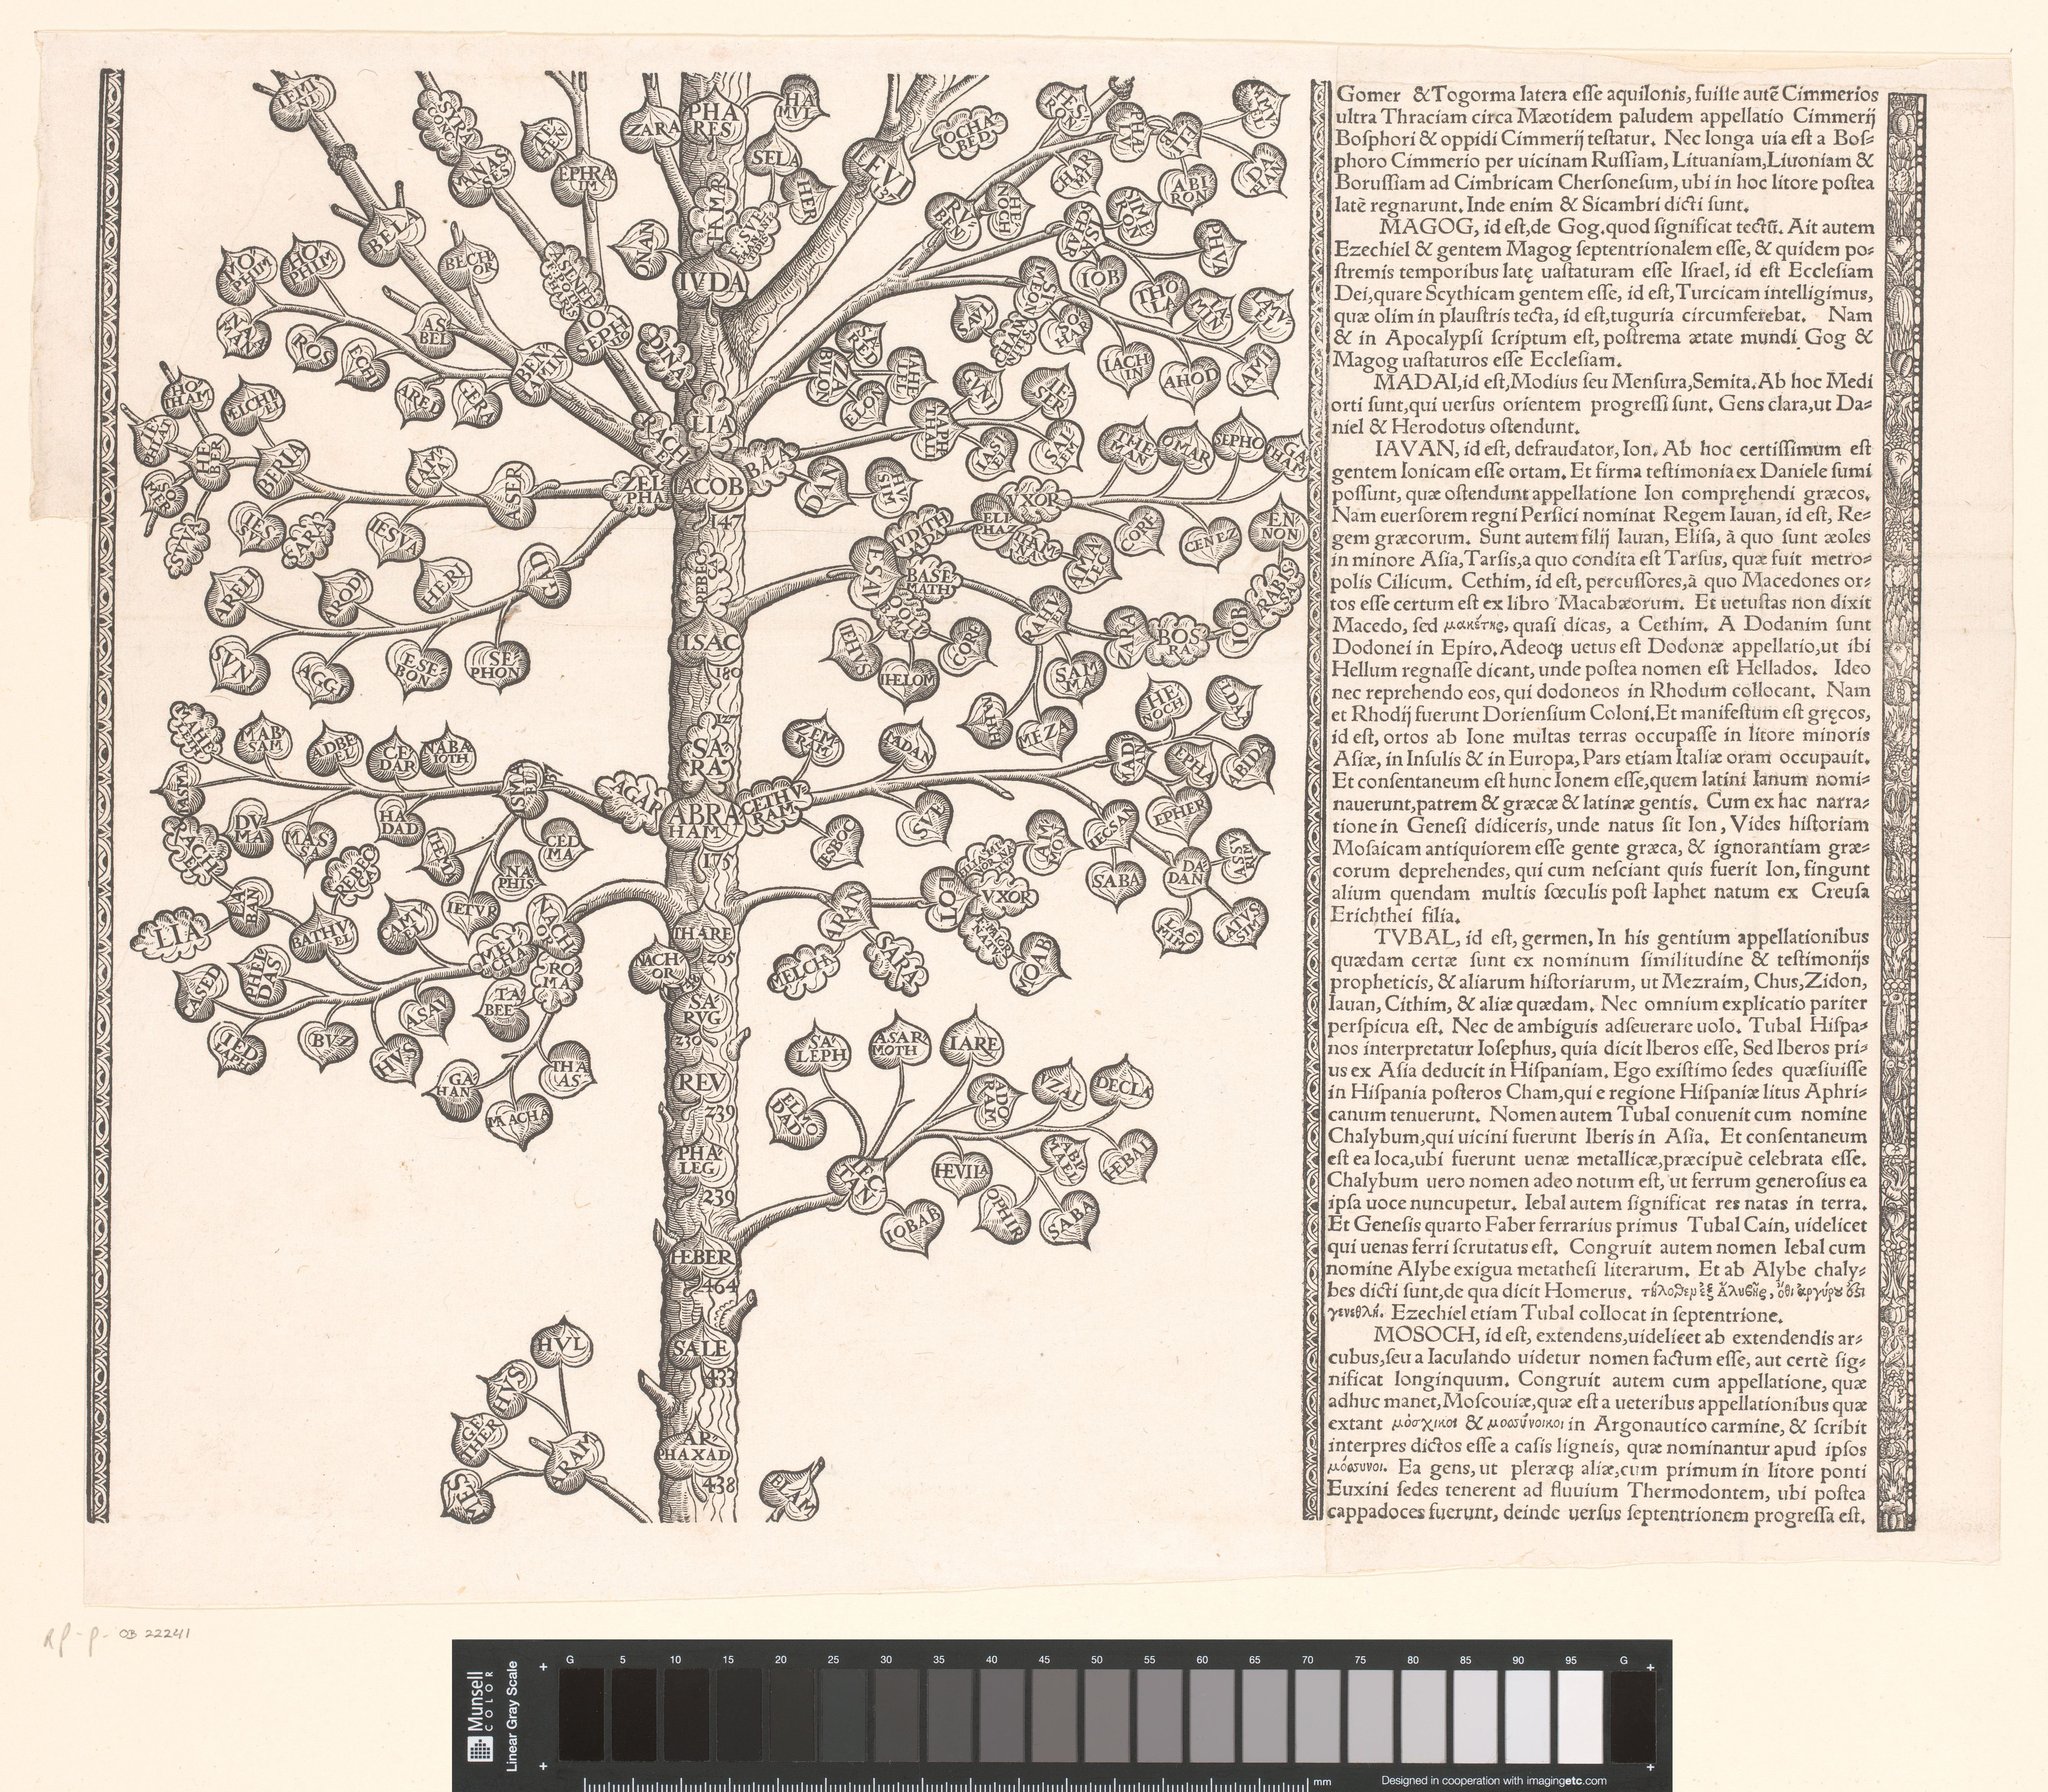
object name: print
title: Stamboom van Christus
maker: tillmann stella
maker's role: print maker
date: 1555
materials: paper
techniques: letterpress printing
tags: family lineage, pedigree, genealogical tree or table, christ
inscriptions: date